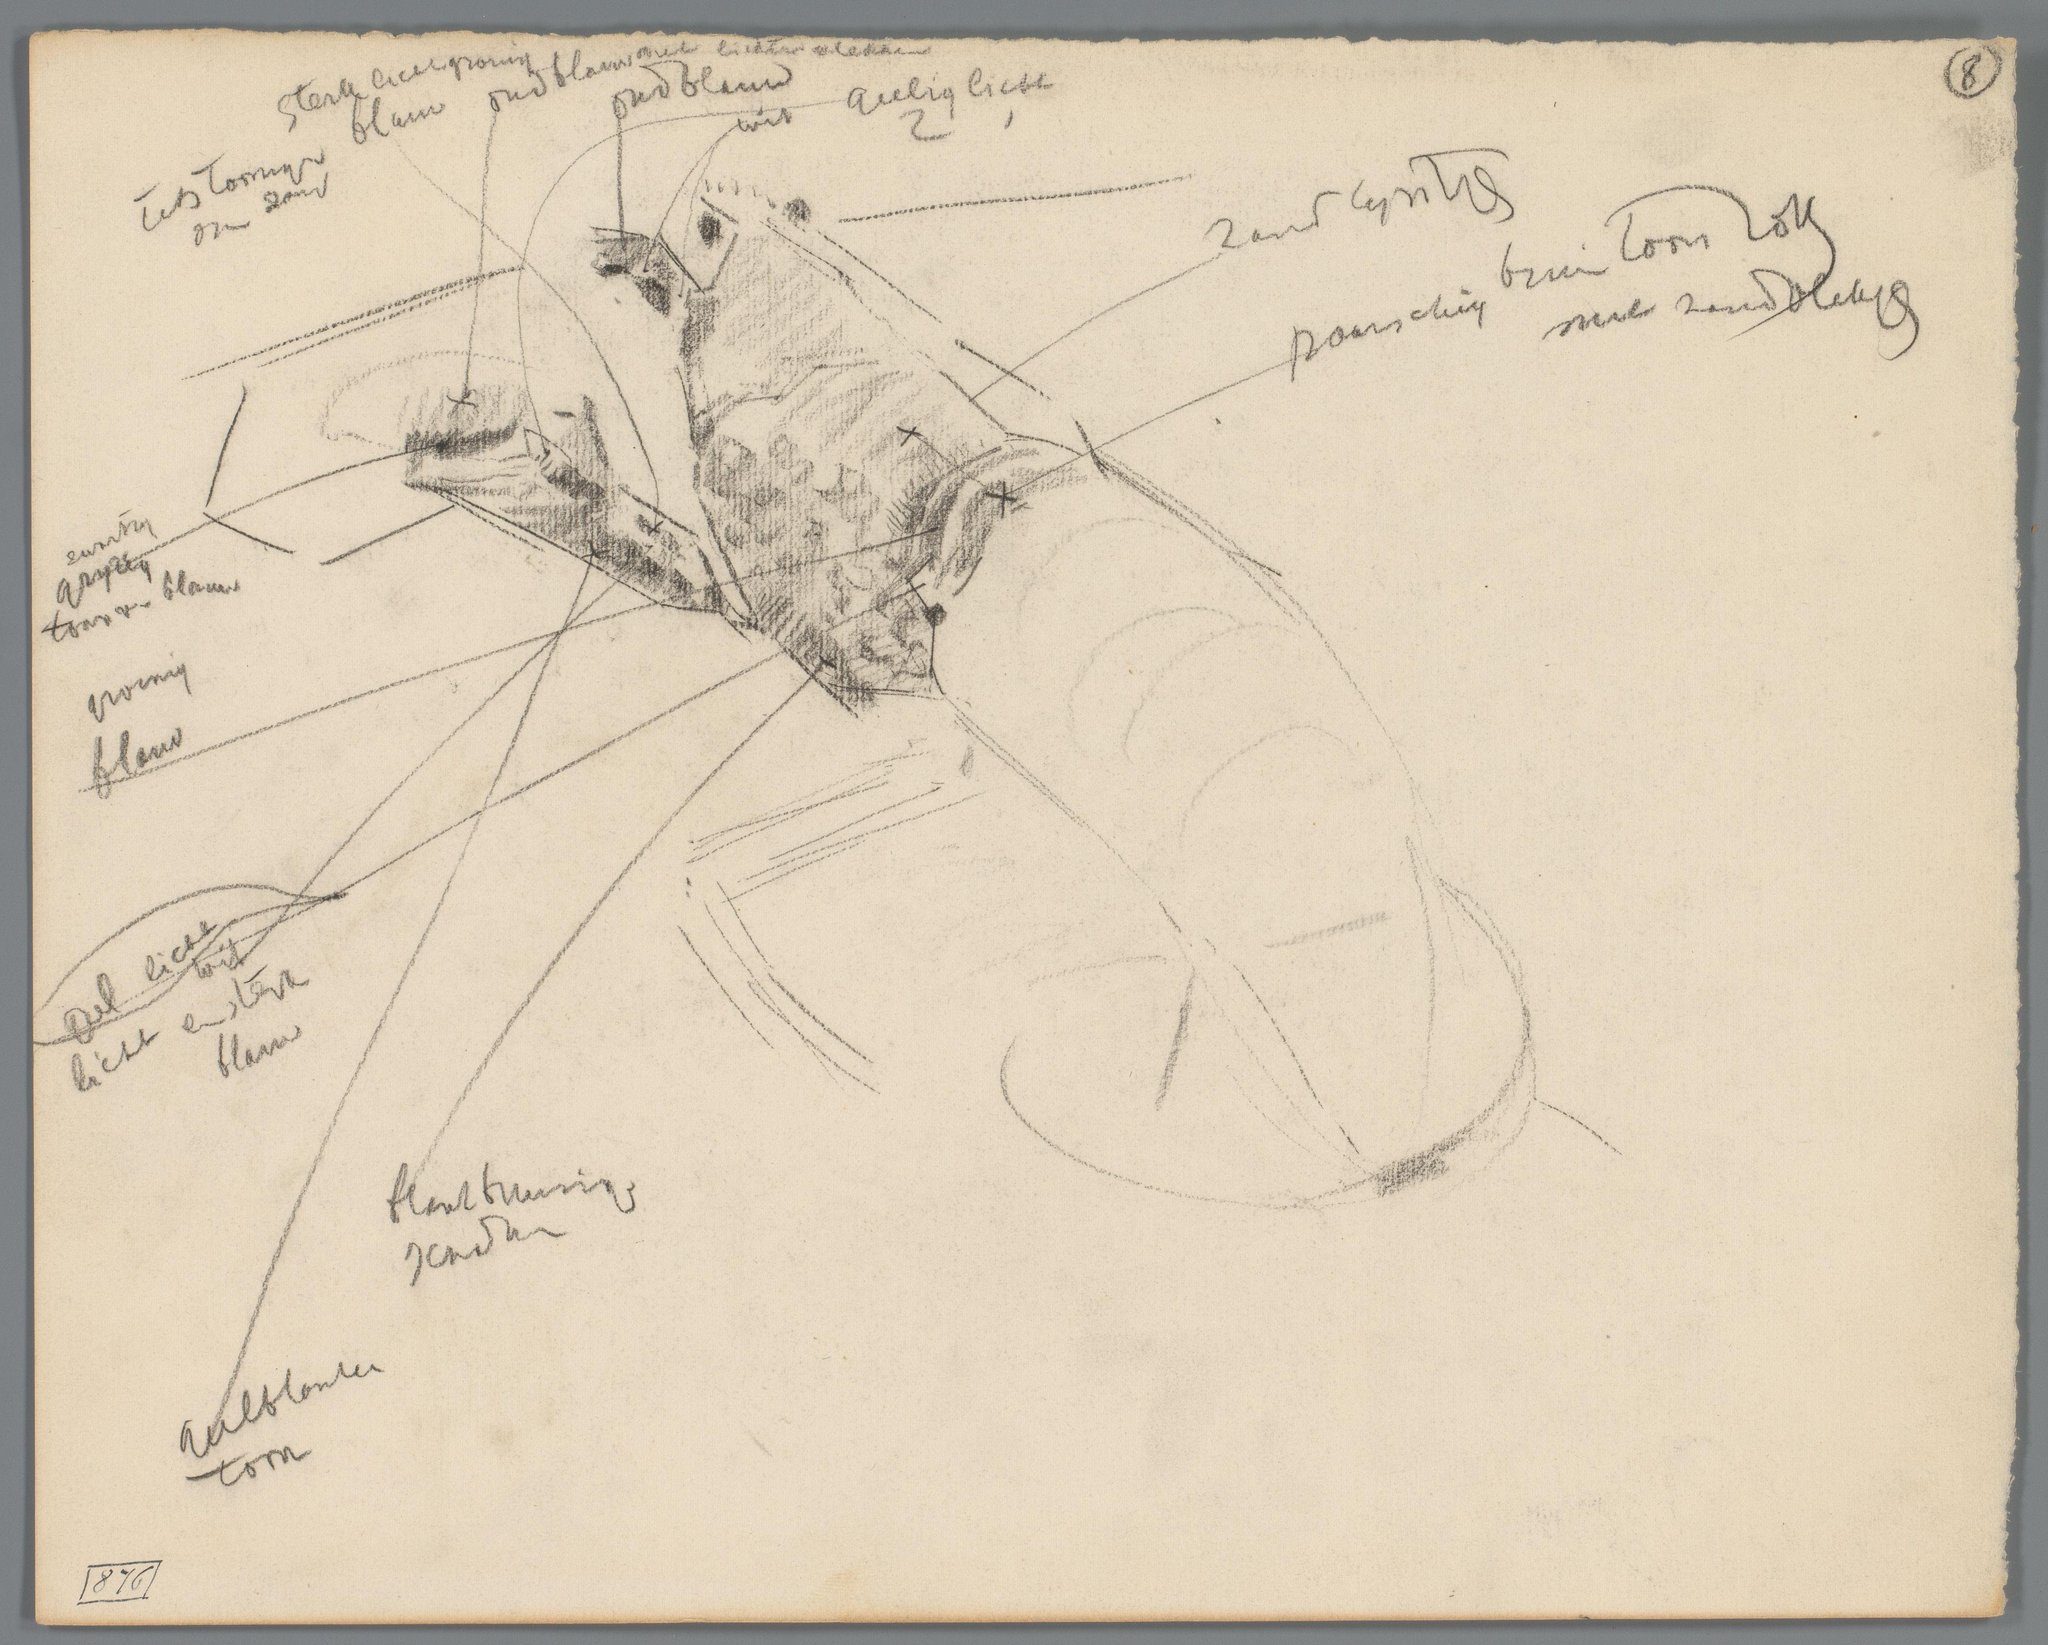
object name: drawing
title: Studie van een kreeft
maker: gerrit willem dijsselhof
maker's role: designer, draughtsman, print maker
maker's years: 1866-1924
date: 1876-1924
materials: chalk, paper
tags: crustaceans: lobster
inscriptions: number: ‘876’, number: ‘8’